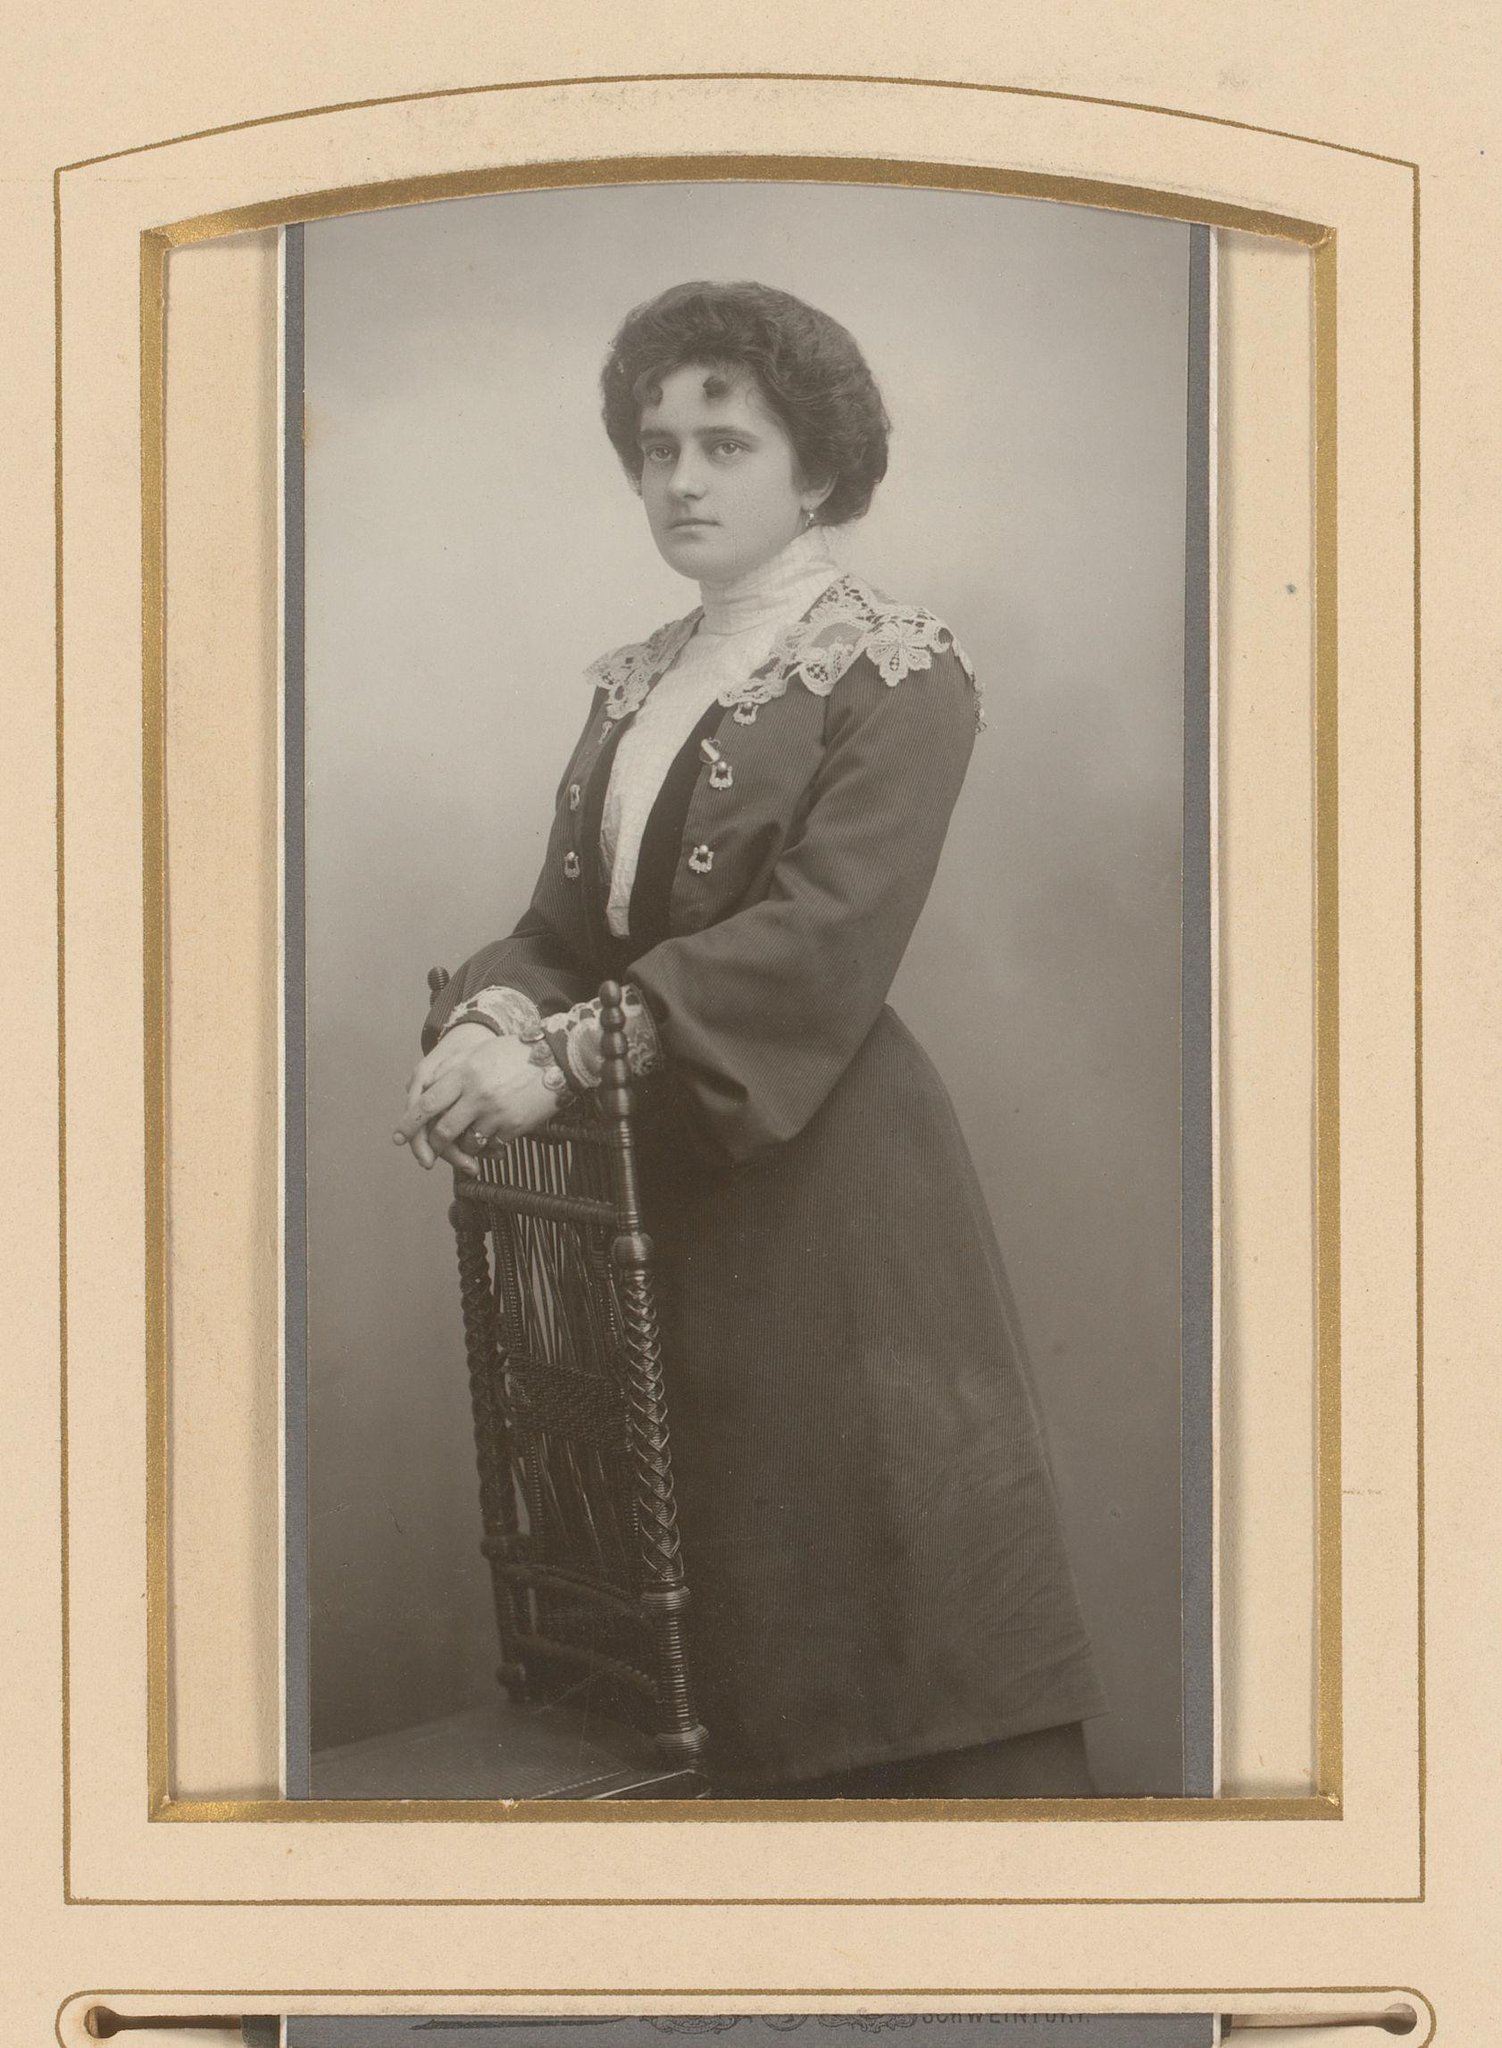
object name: cabinet photograph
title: Portret van een staande vrouw bij een stoel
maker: eduard uhlenhuth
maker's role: fotograaf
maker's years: 1853-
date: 1897-1920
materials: cardboard, photographic support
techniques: matte daylight collodion silver print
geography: coburg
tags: historical persons - bb - woman, chair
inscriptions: inscription: ‘(...)/ Professor E. Uhlenhuth/ (...)/ Coburg/ am Albertplatz./ Schweinfurt, gegenüber dem Schrotthurm./ Von diesem Bilde kann stets nachbestellt und jede/ Art Vergrösserung angefertigt werden.’